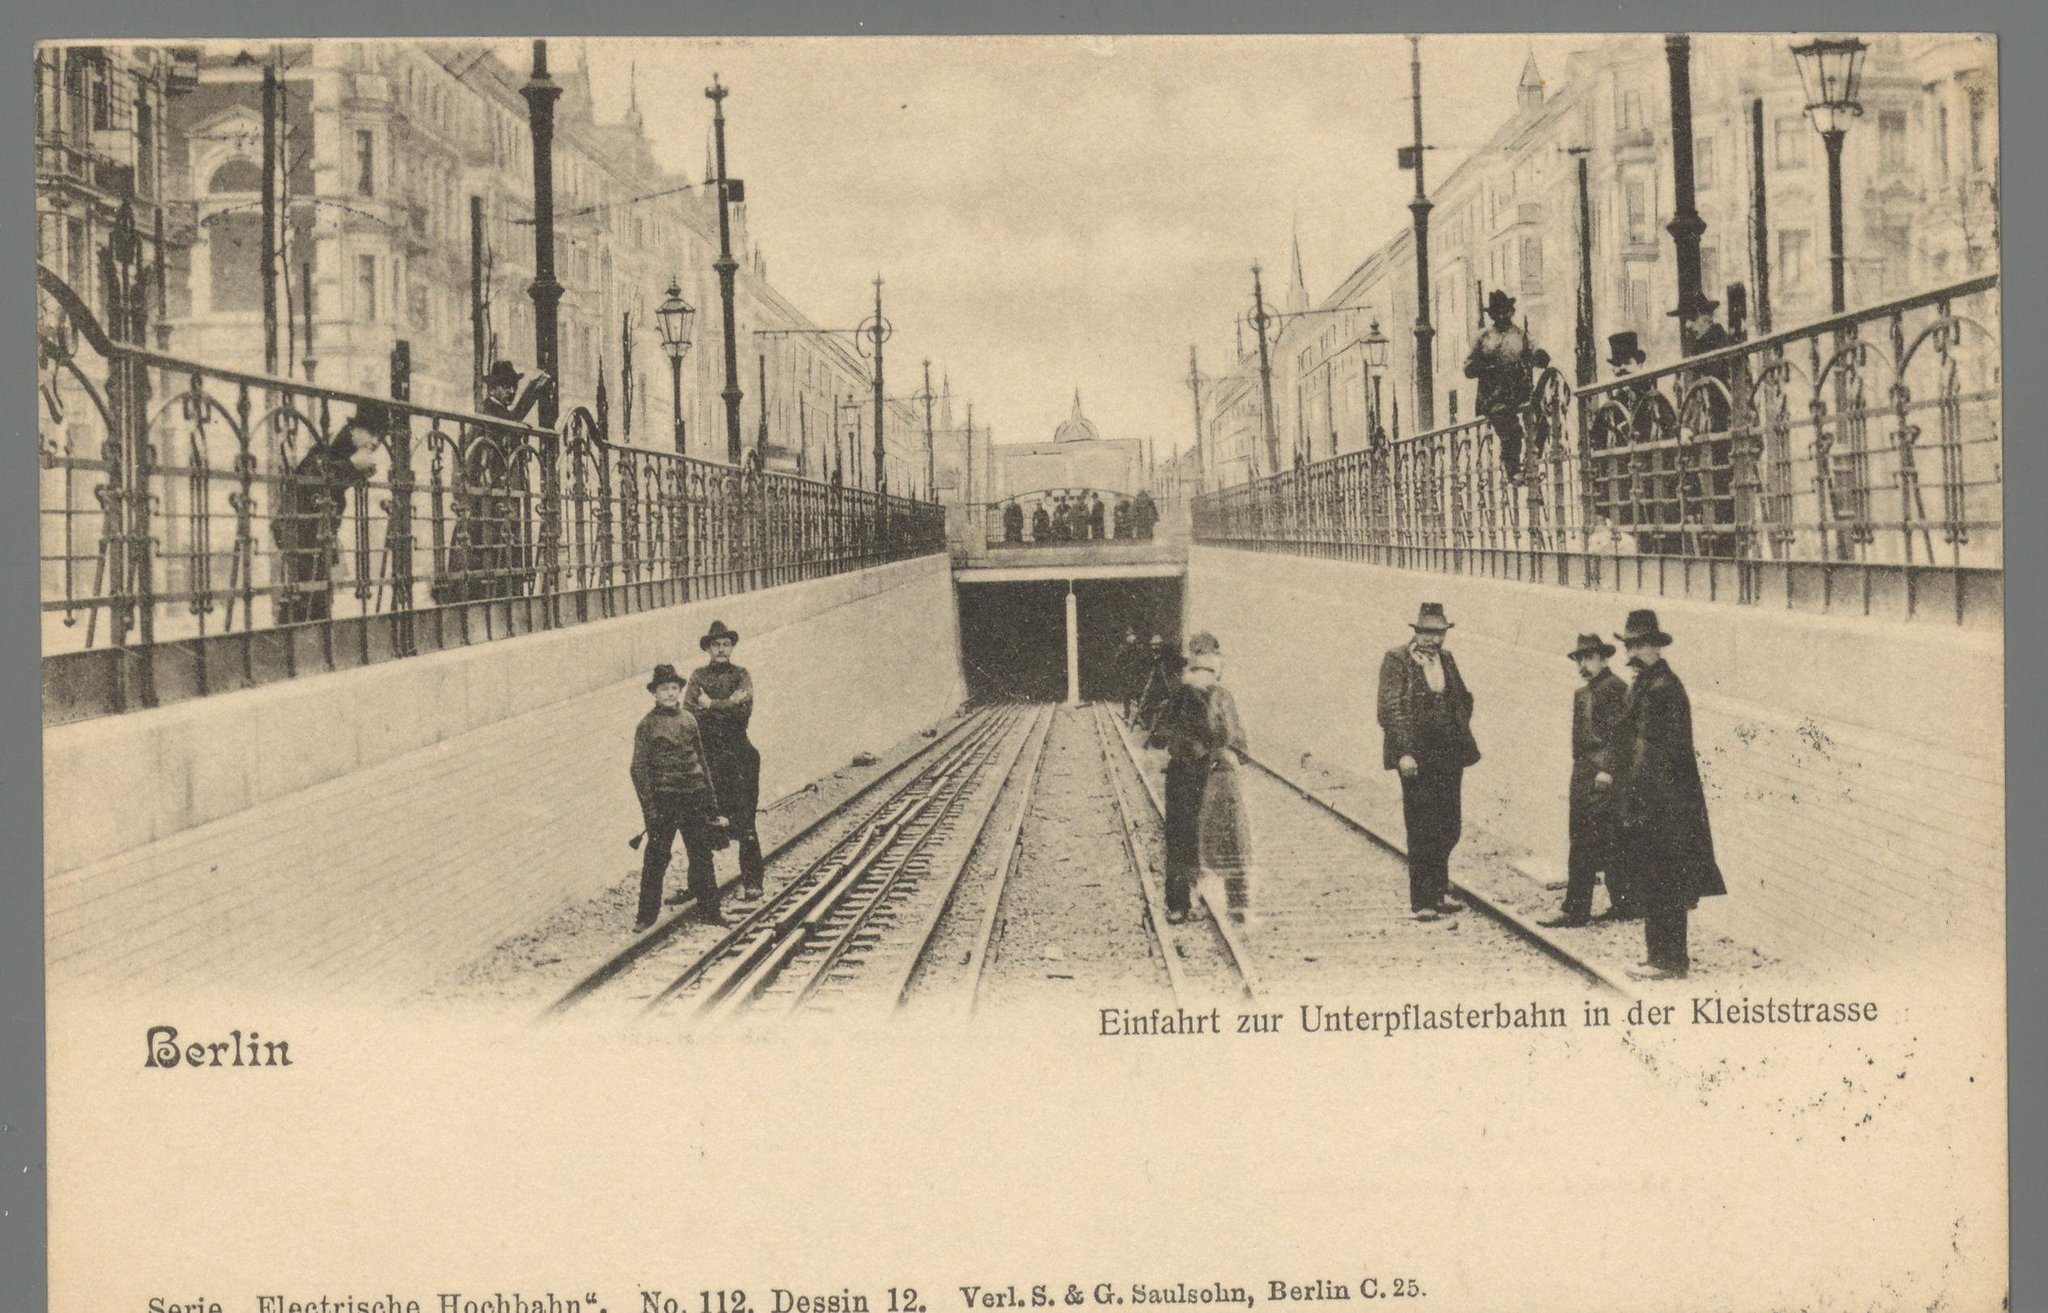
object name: ansichtkaart, prentbriefkaart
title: Berlin. Einfahrt zur Unterpflasterbahn in der Kleistrasse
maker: Anonymous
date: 1885-1903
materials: cardboard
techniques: photograph, writing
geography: berlin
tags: underground railway, 'métro', street, berlin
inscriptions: postage stamp